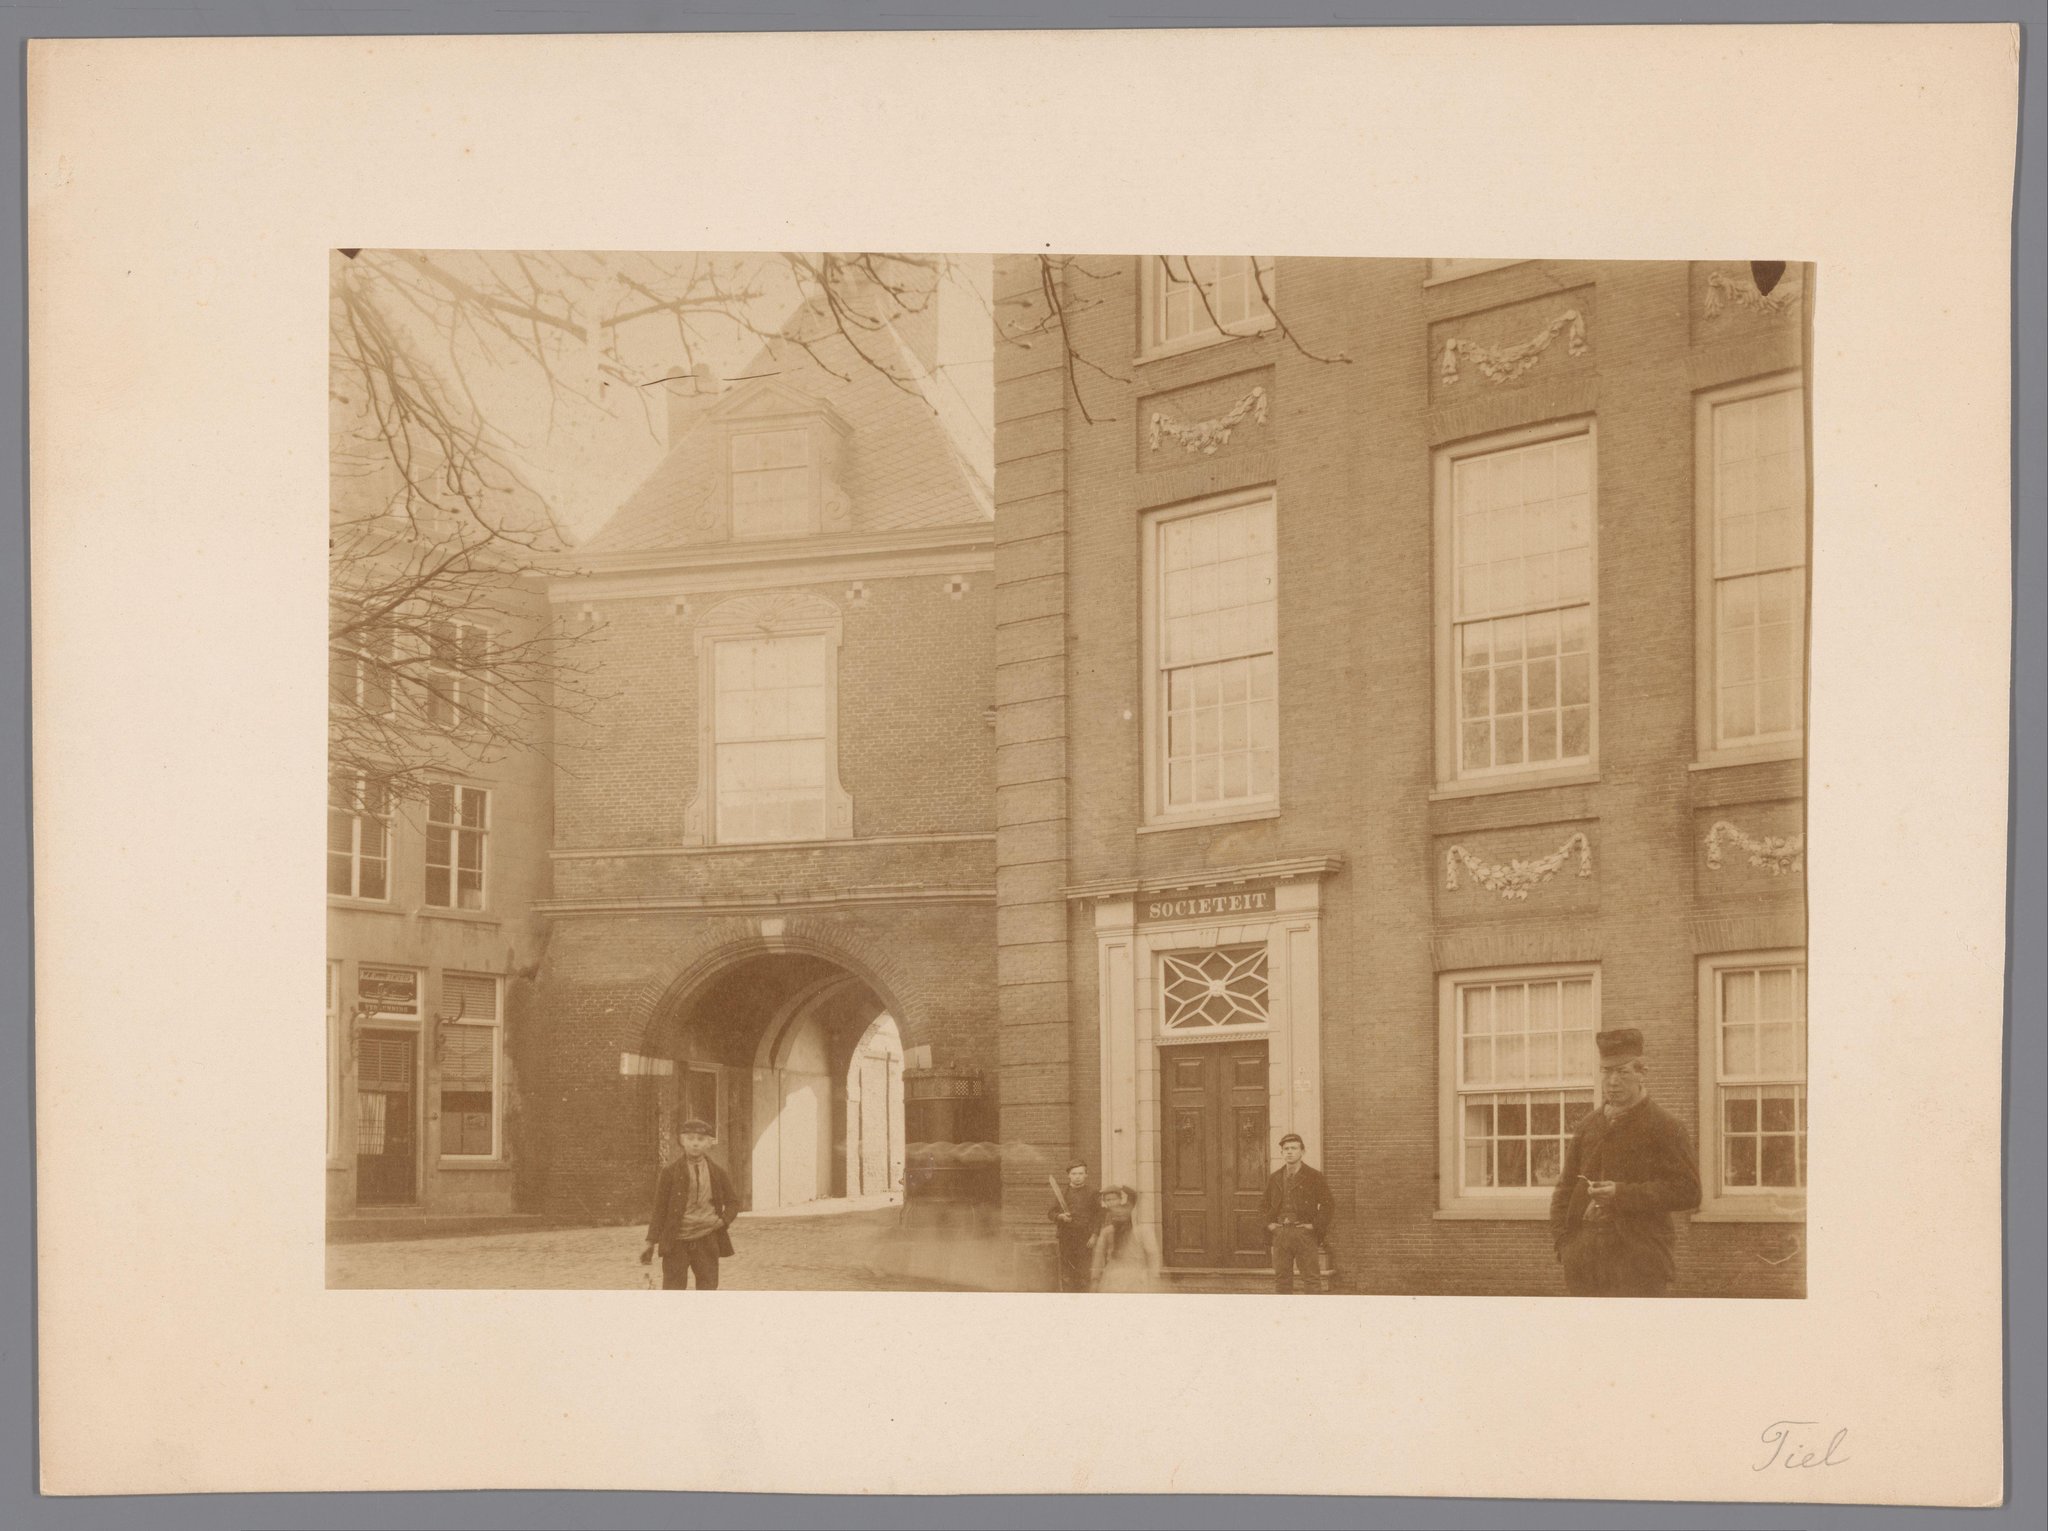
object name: photograph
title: Stadszijde van de Waterpoort te Tiel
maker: anoniem (monumentenzorg)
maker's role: fotograaf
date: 1893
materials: cardboard, photographic support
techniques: albumen print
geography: tiel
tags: city-gate (+ city(-scape) with figures, staffage)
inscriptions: annotation: ‘Tiel’, annotation: ‘Tiel/ Water of Kleberschepoort b/d Waal (stadszijde)/ Maart 1893’